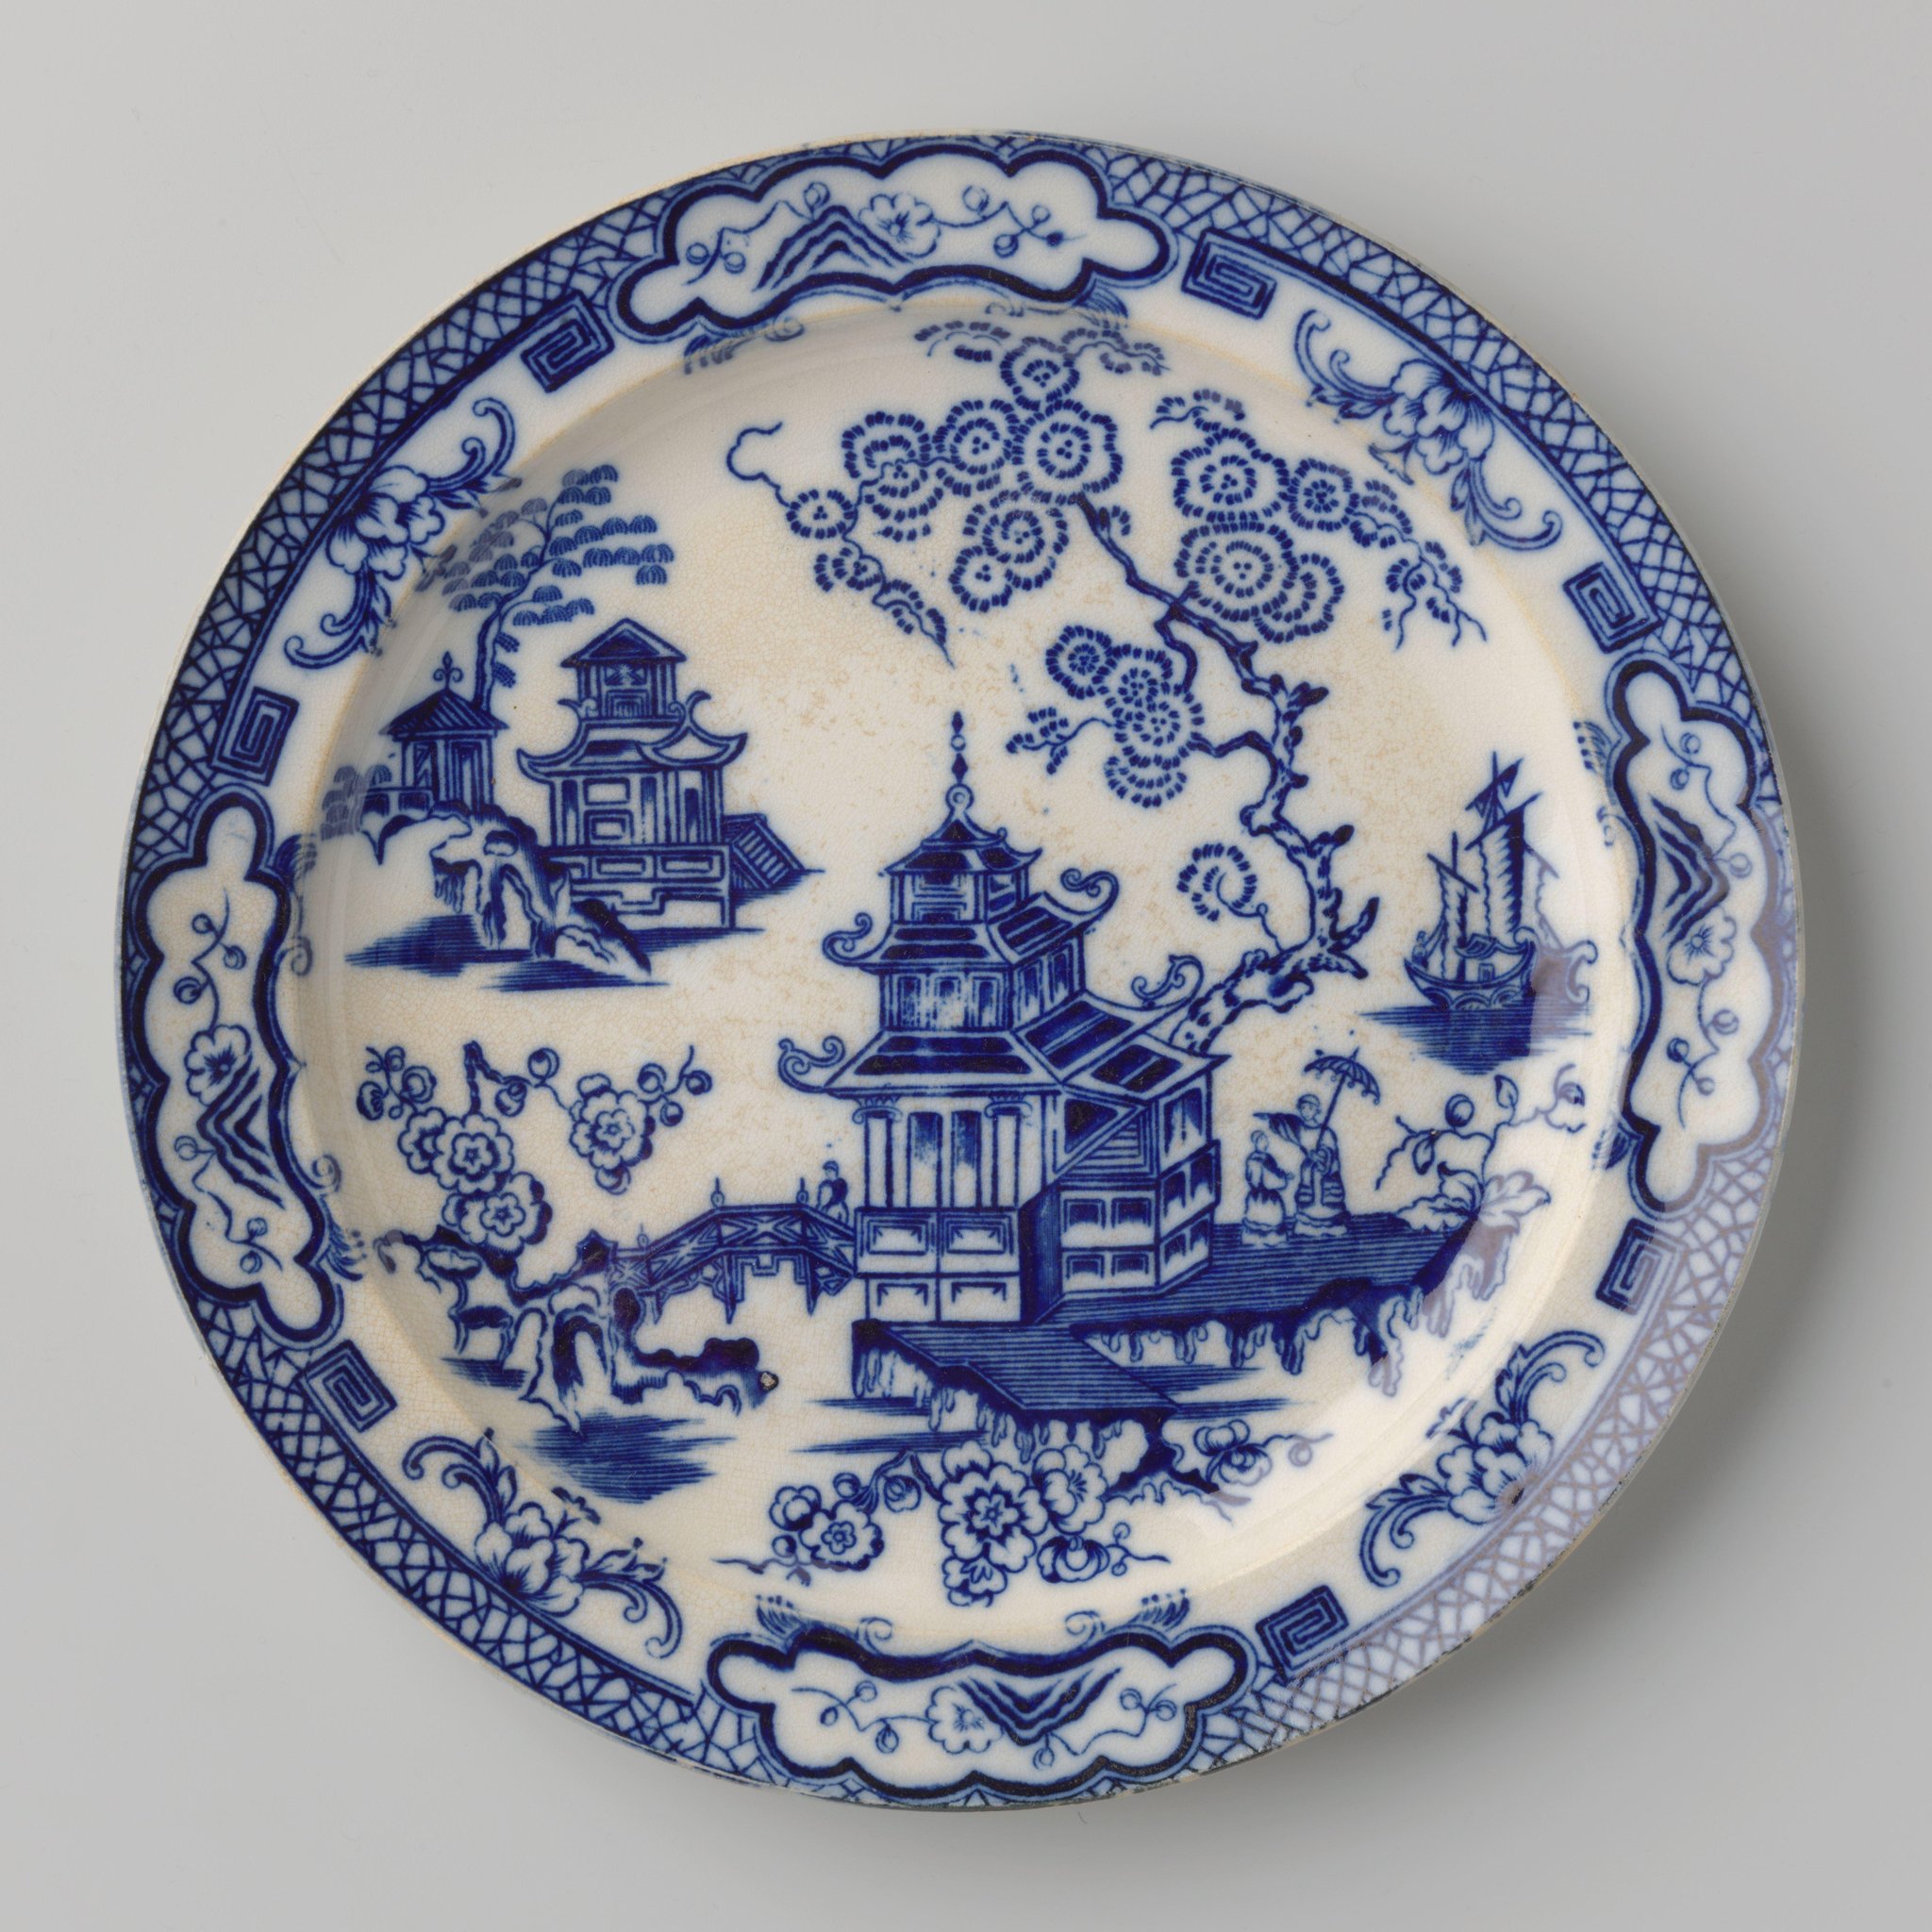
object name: plate dish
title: Bord, met op het plat twee gebouwen en een schip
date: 1859-1863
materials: creamware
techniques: transfer decoration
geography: maastricht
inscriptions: check stamp: ‘G. ster L.’, mark: ‘TONQUIN’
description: Bord van aardewerk met vloeiblauw transferdecor. Op het plat twee gebouwen en een schip. De rand met vier cartouches, waarin onder andere bloemen. Tussen de cartouches vier bloemen.